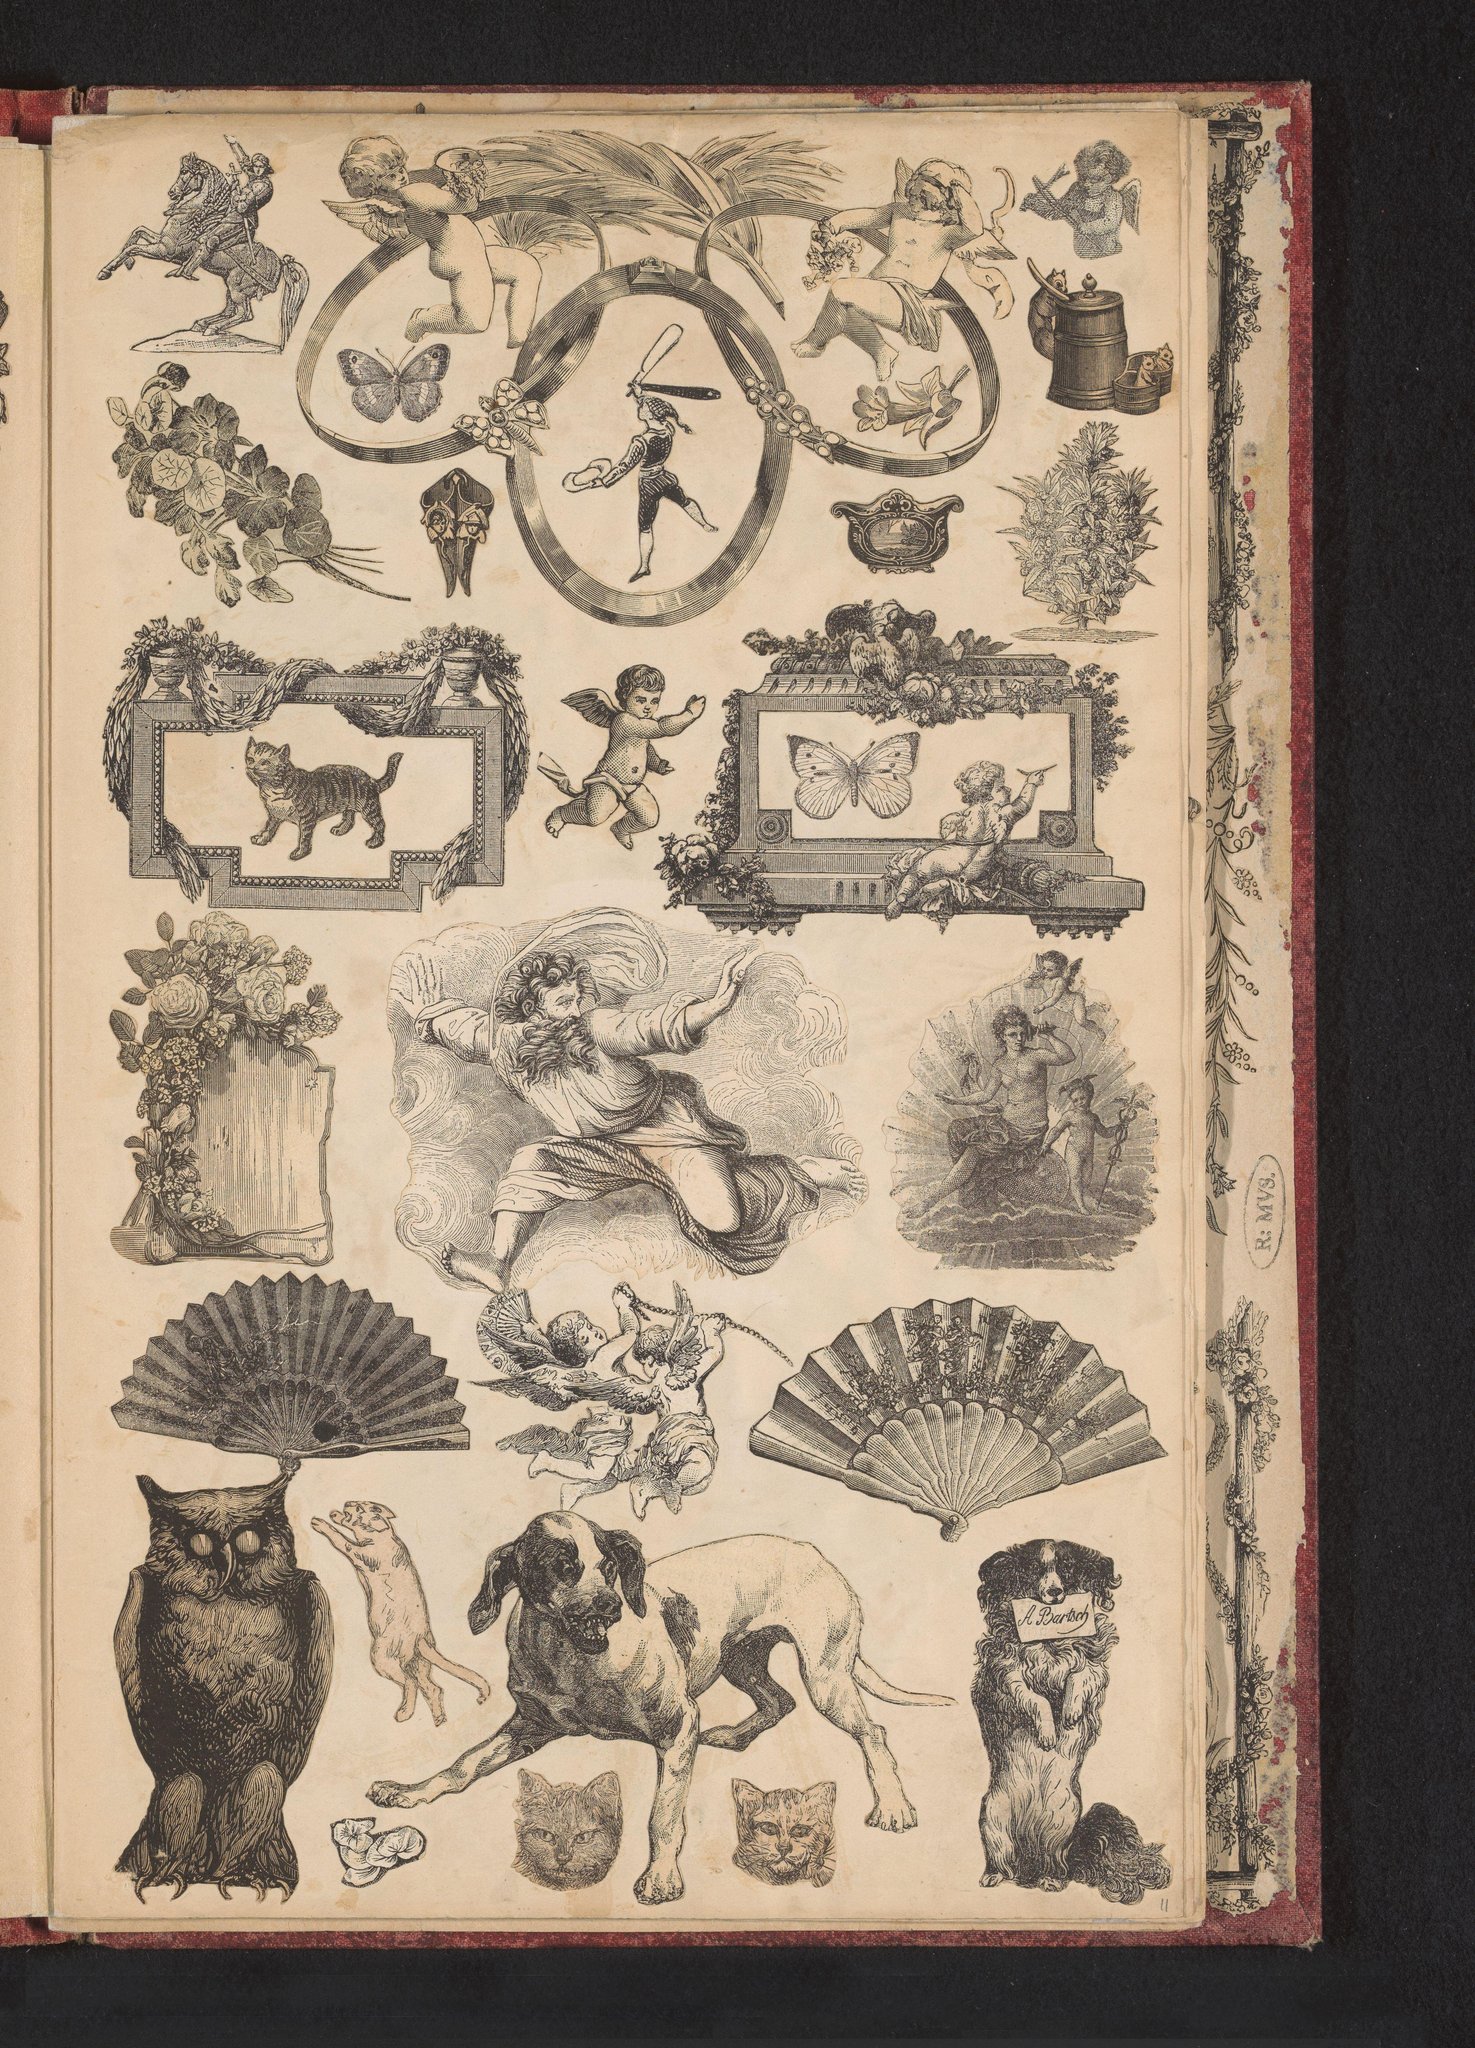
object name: collage visual work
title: Collage van uitgeknipte prenten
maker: Anonymous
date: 1870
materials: paper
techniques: engraving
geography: paris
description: Collage van uitgeknipte prenten. Onderdeel van een album met 32 bladen, aan beide zijden beplakt met uitgeknipte prenten, vermoedelijk afkomstig uit 19e-eeuwse tijdschiften.